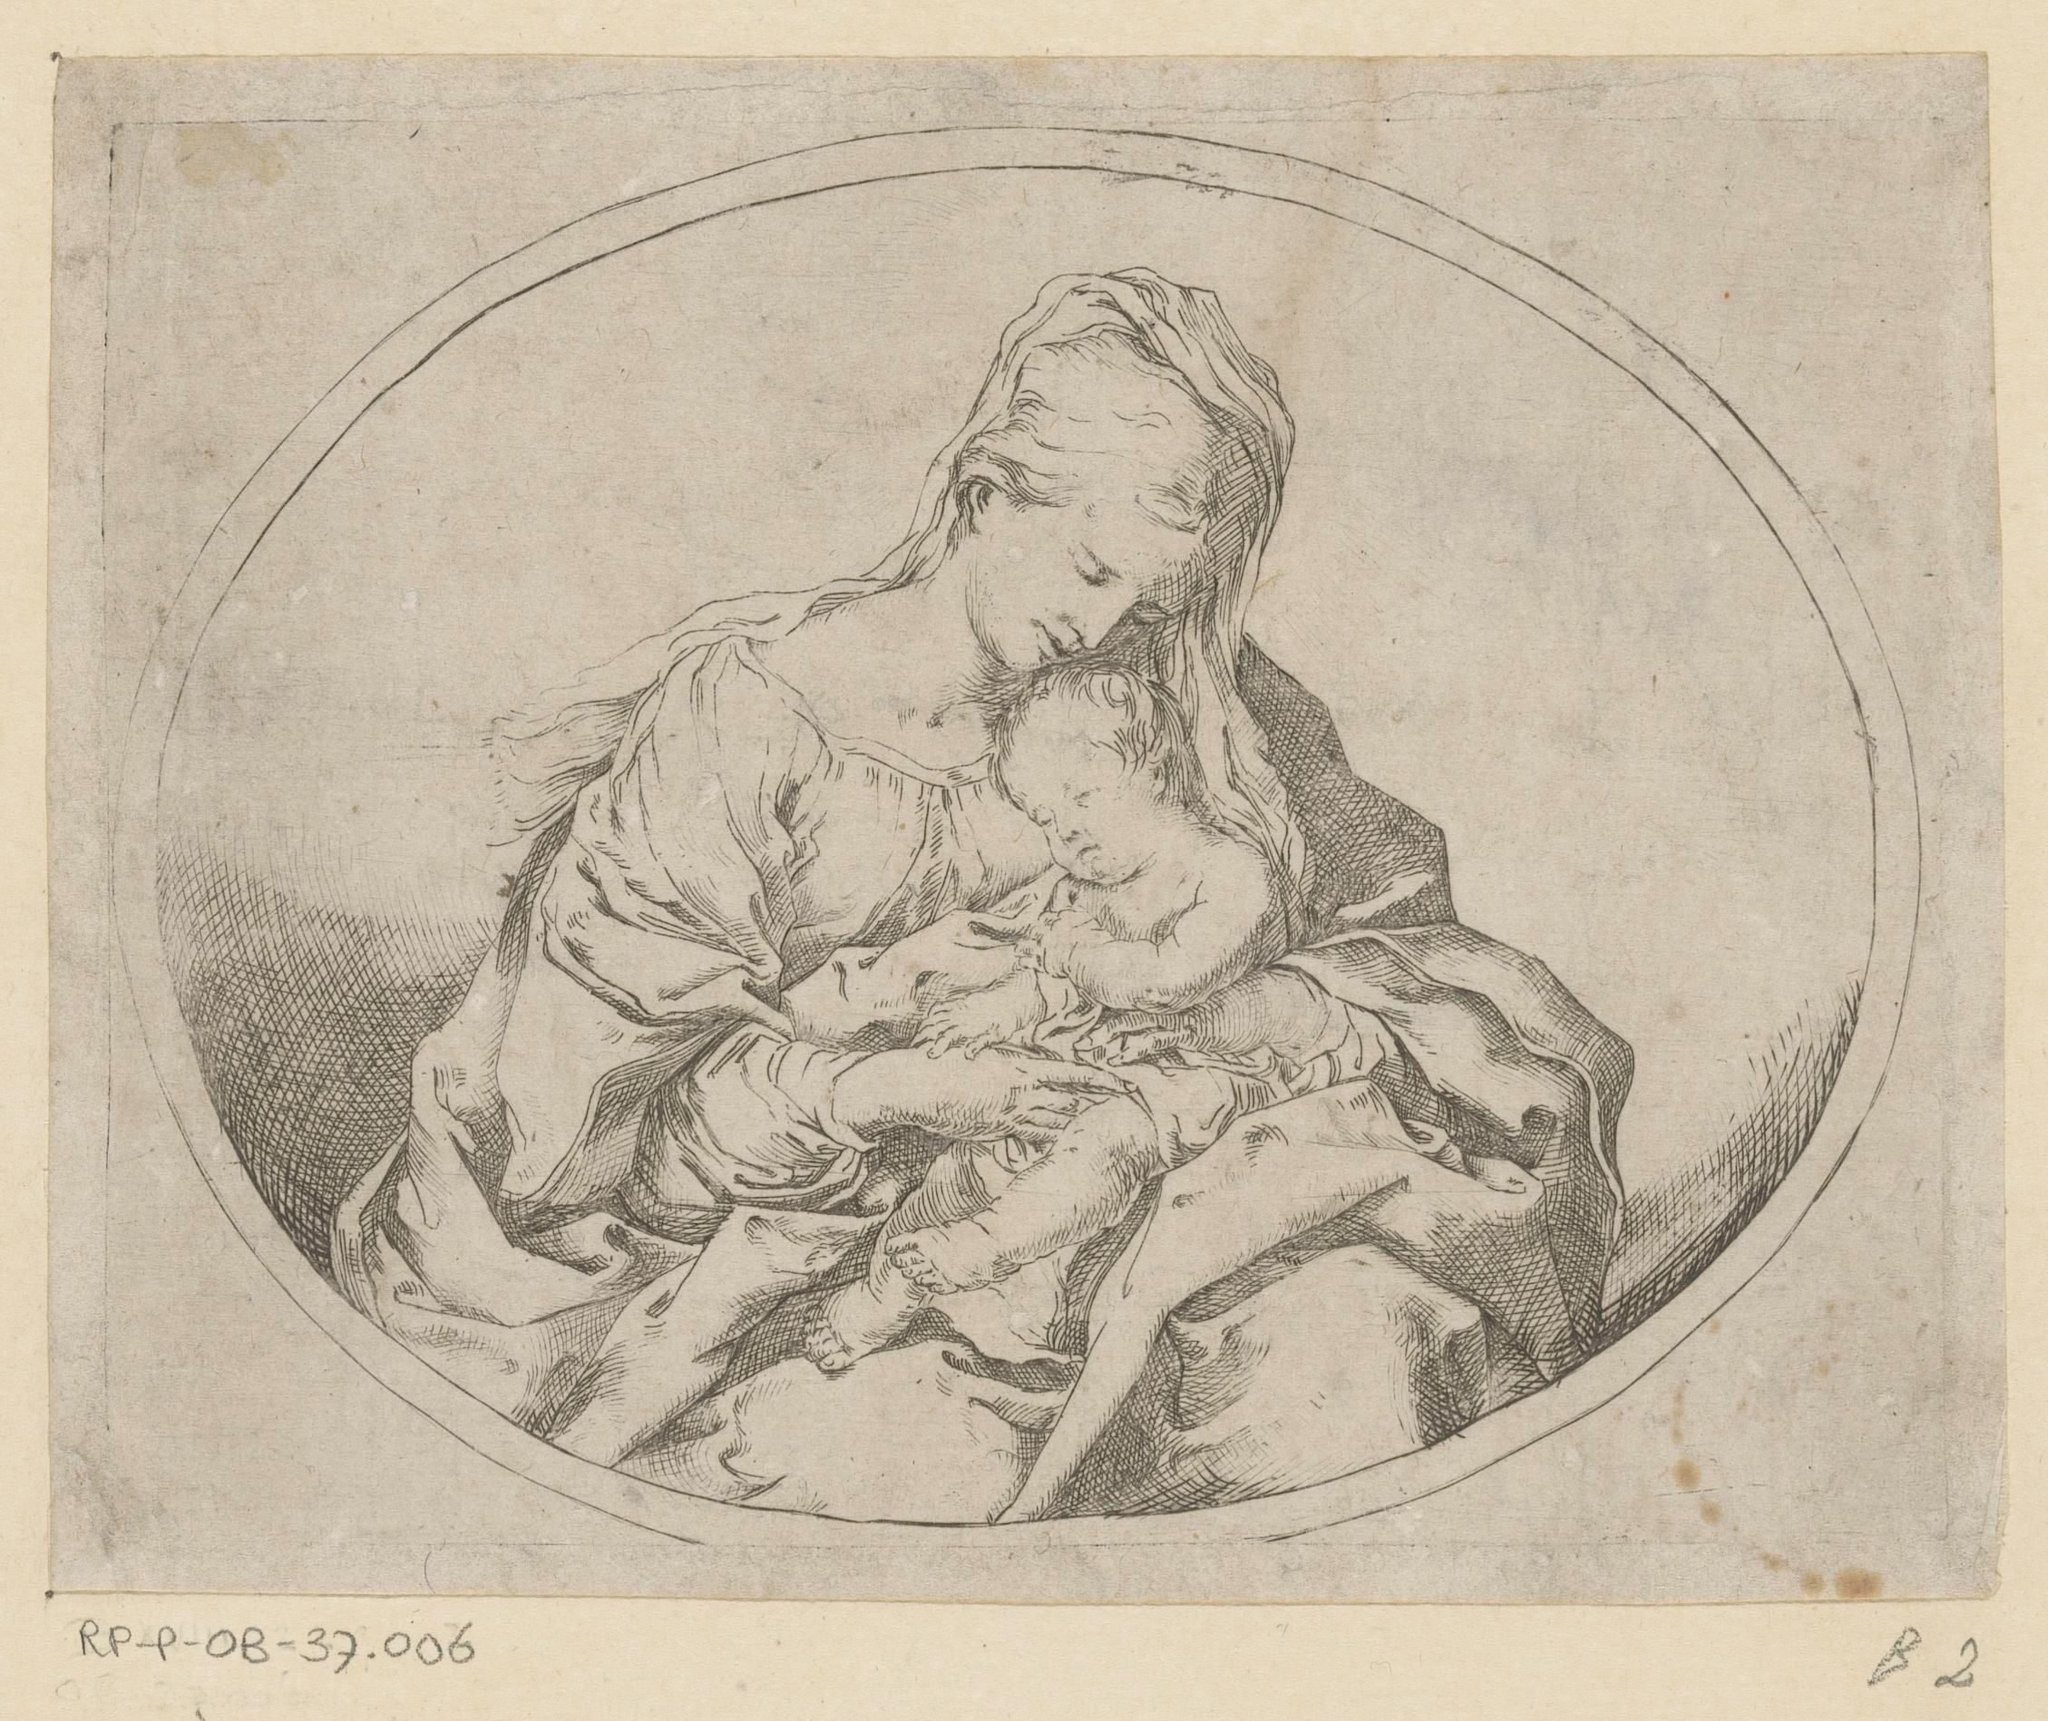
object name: print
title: Maria met Kind in een ovaal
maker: Anonymous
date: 1585-1642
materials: paper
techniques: etching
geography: italy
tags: madonna: i.e. mary with the christ-child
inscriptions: collector's mark: Lugt 240